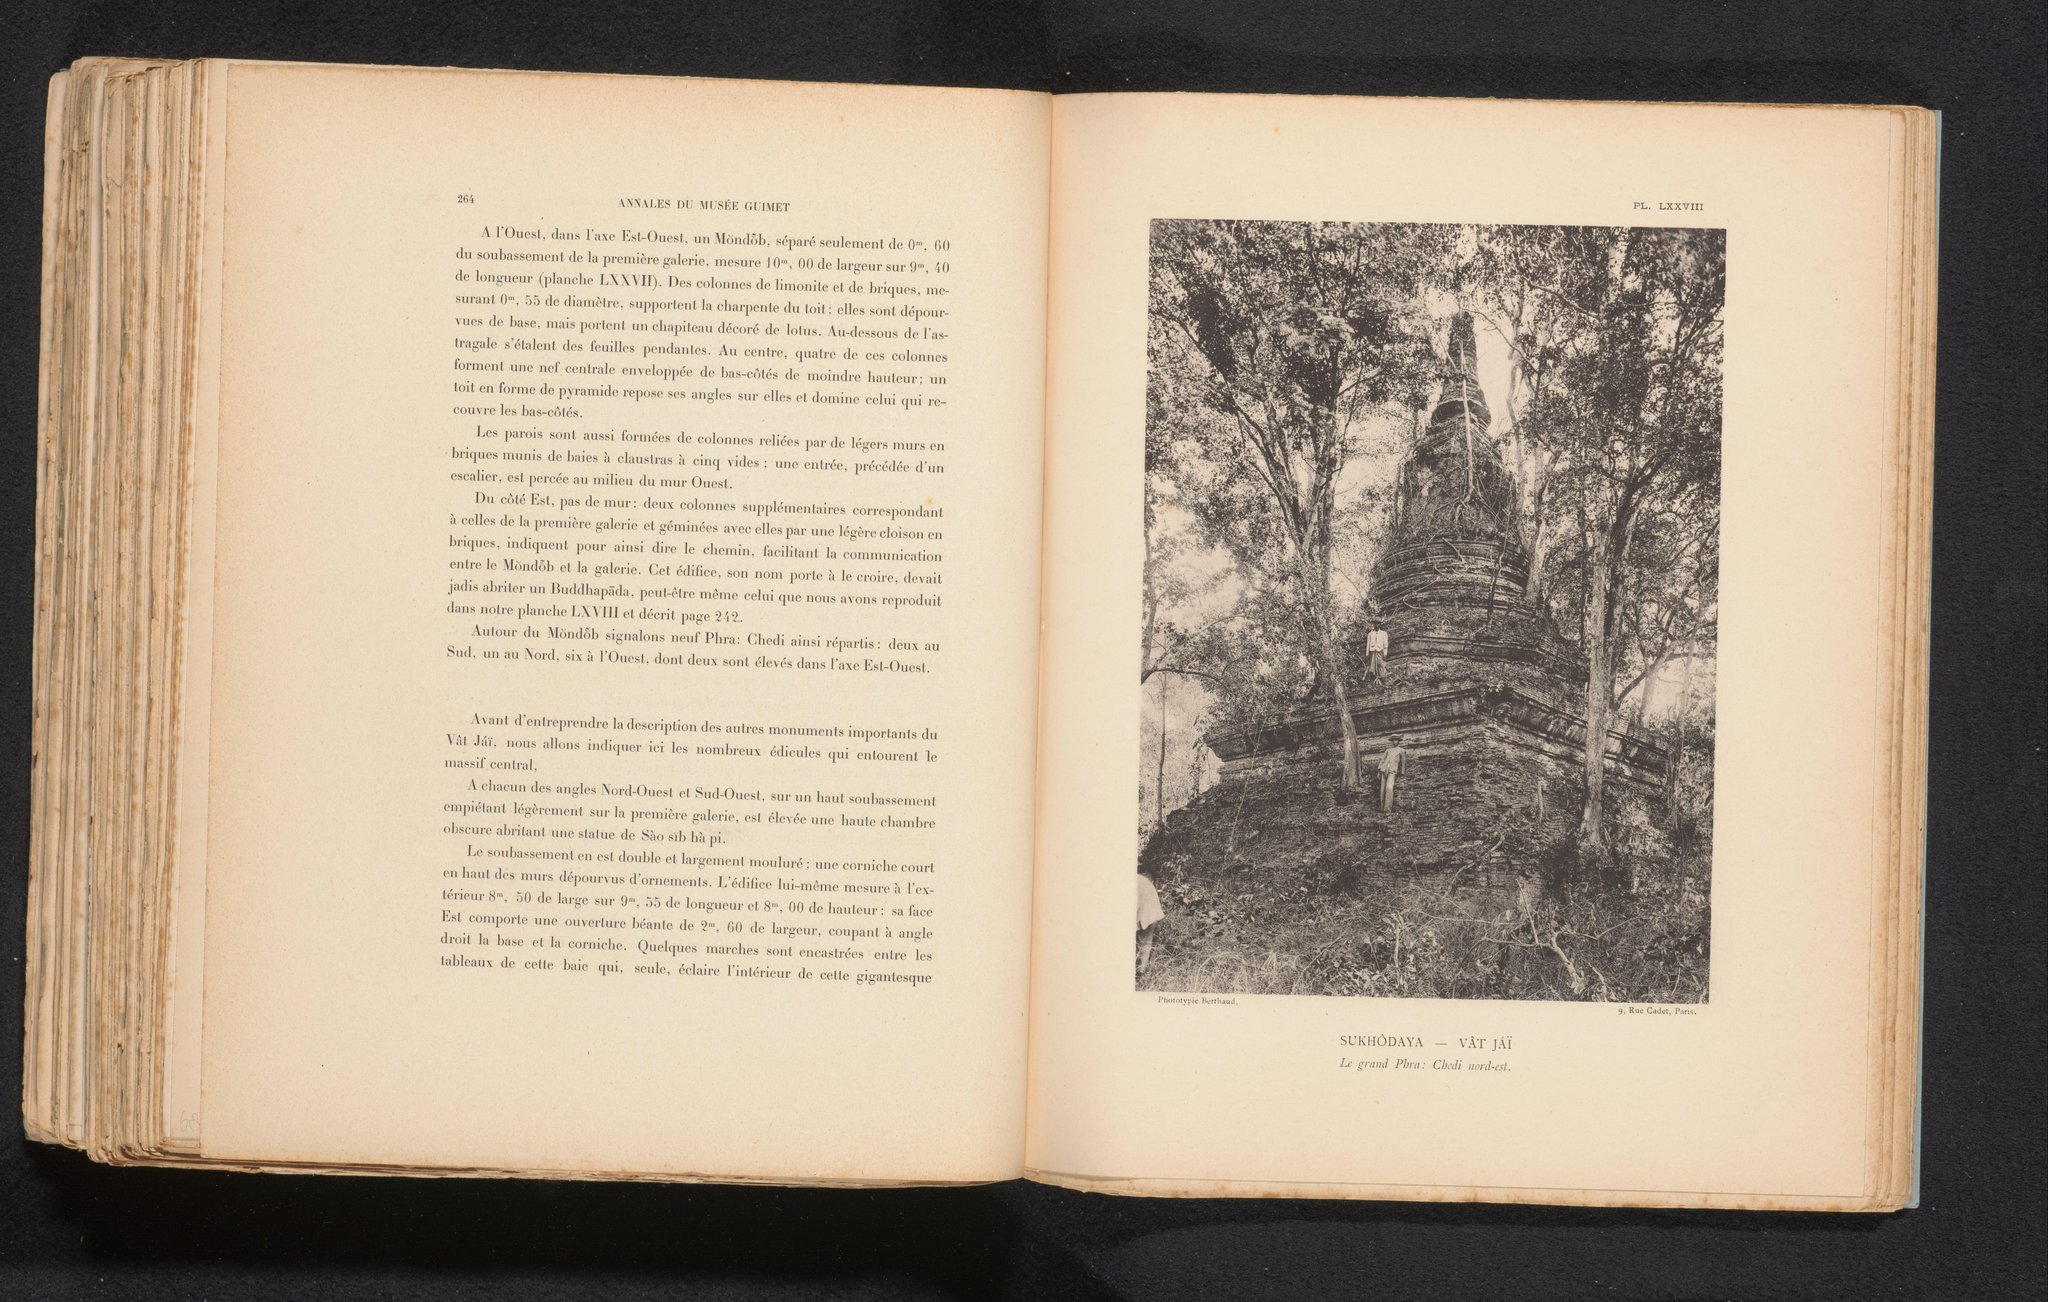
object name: photomechanical print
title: Twee onbekende mannen bij een tempel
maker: michel berthaud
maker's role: publisher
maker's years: 1845-1912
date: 1890-1895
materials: paper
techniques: photograph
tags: temple, shrine ~ hinduism, buddhism, jainism, adult man, forest, wood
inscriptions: inscription: ‘Le gran Phra: Chedi nord-est’, inscription: ‘Pl. LXXVIII’, collector's mark: ‘Société d'Emulation de l'Ain/ Bourg/ Bibliothèque’